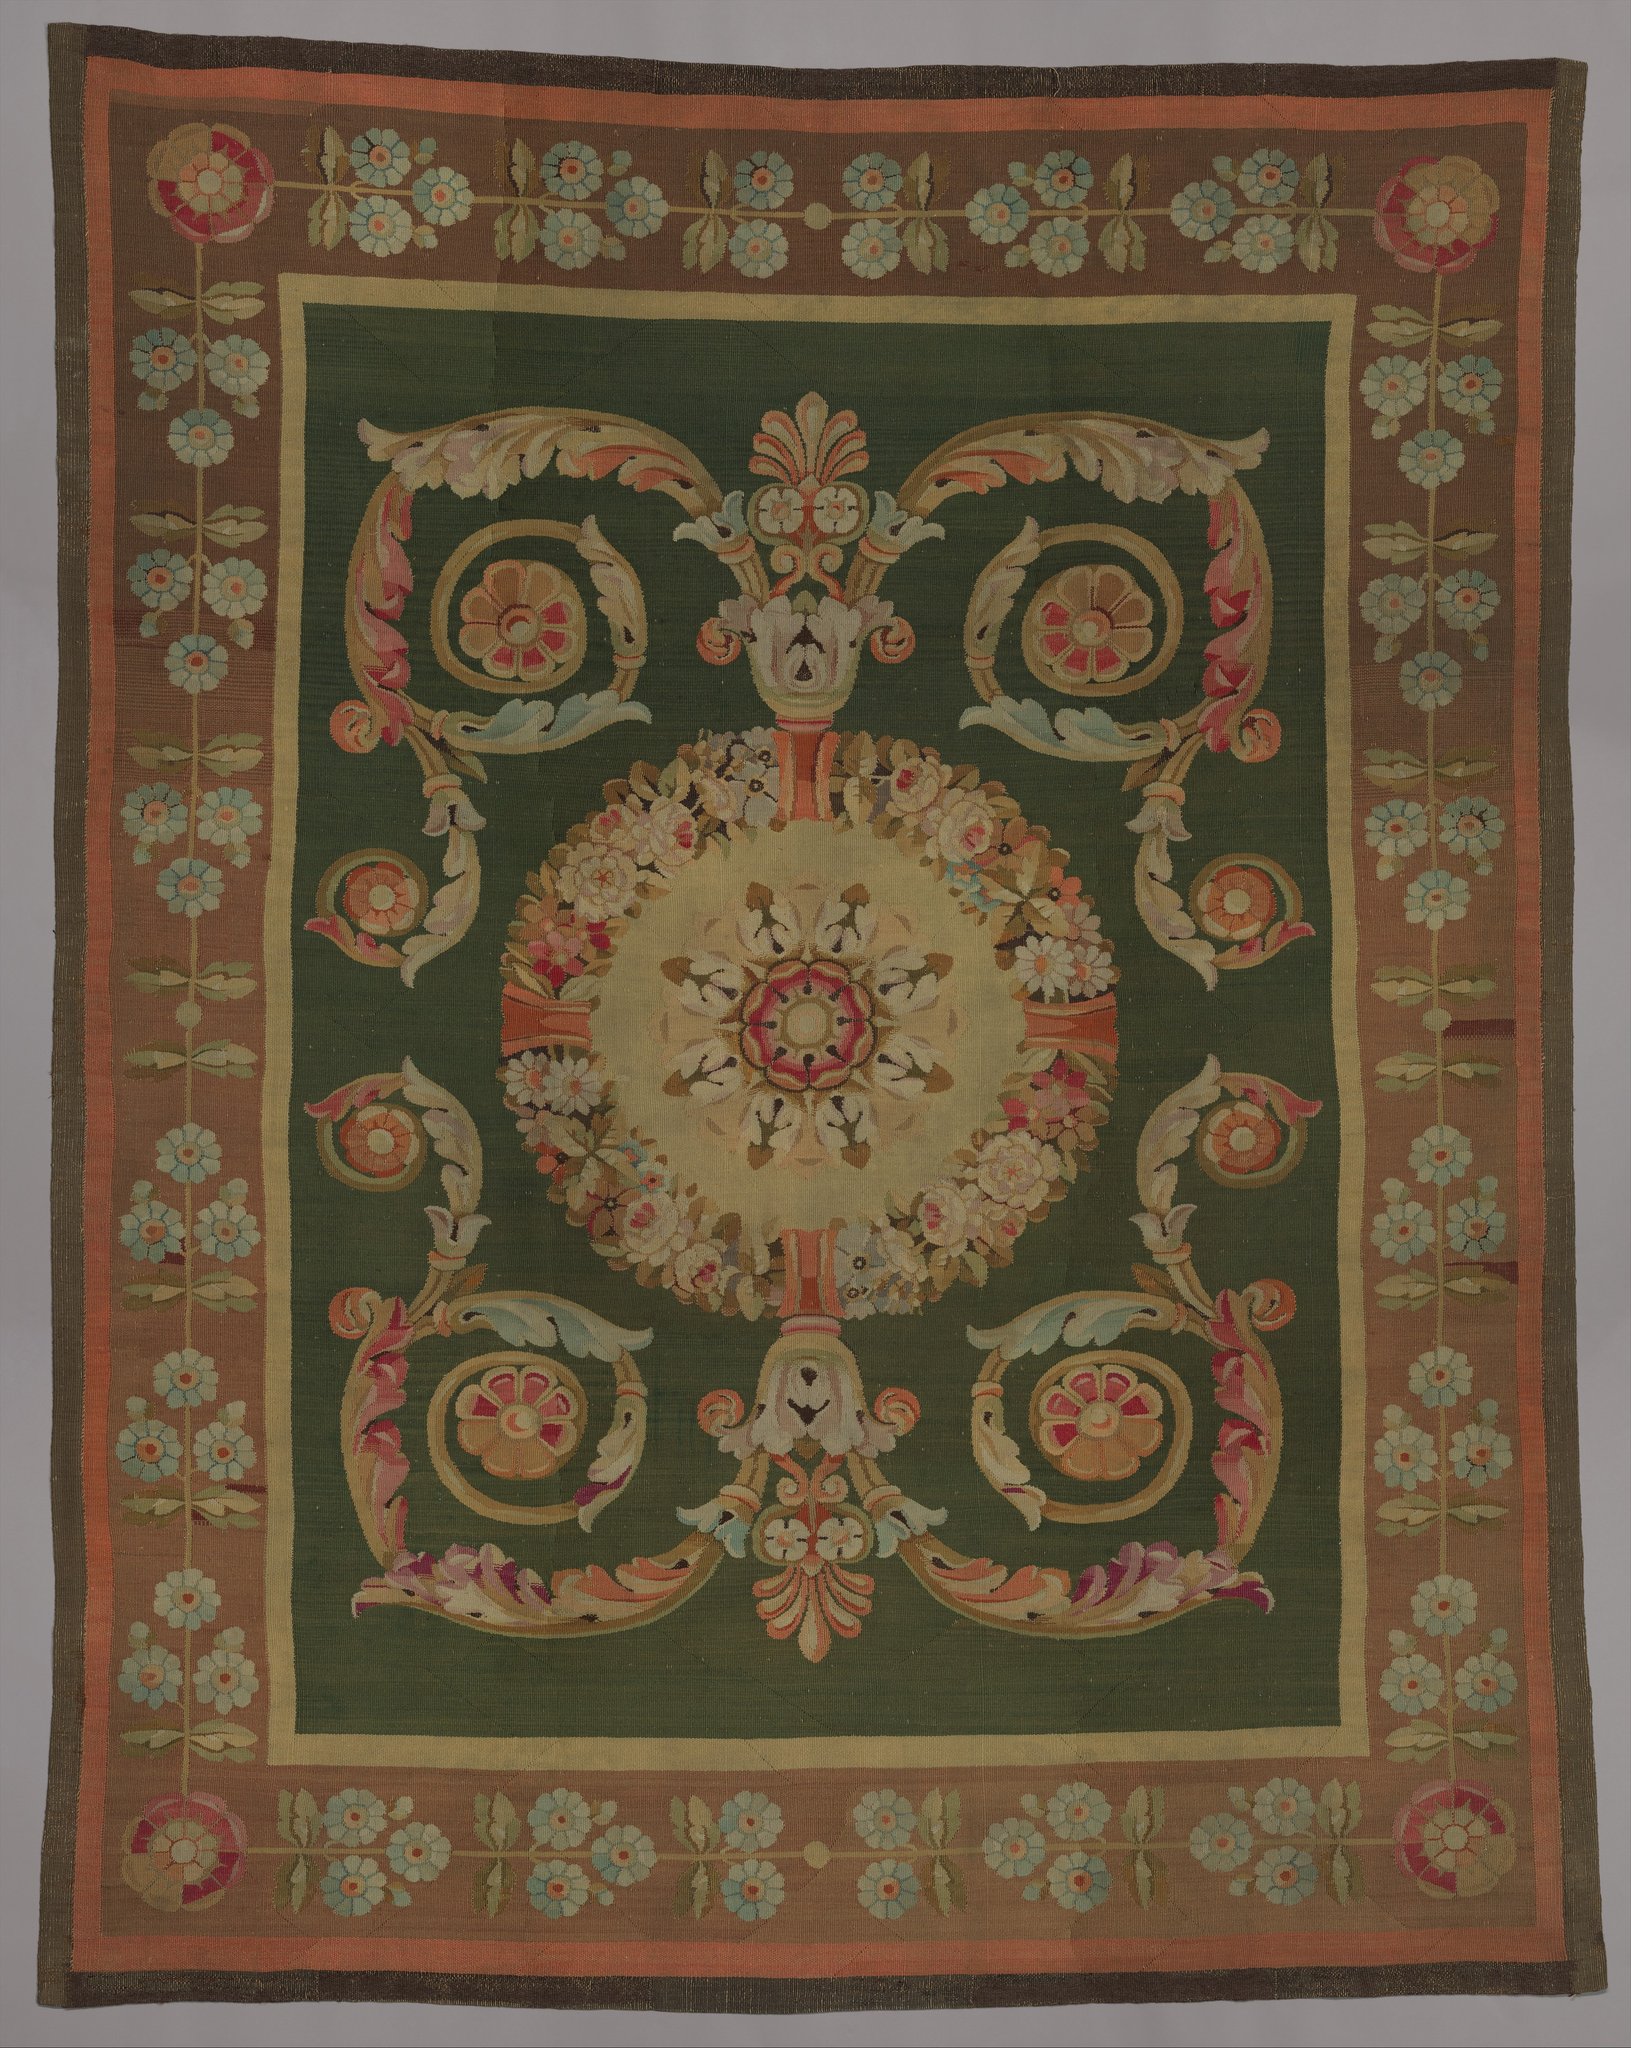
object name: carpet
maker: aubusson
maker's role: manufactory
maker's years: 1665-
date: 1814-1830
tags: flowers